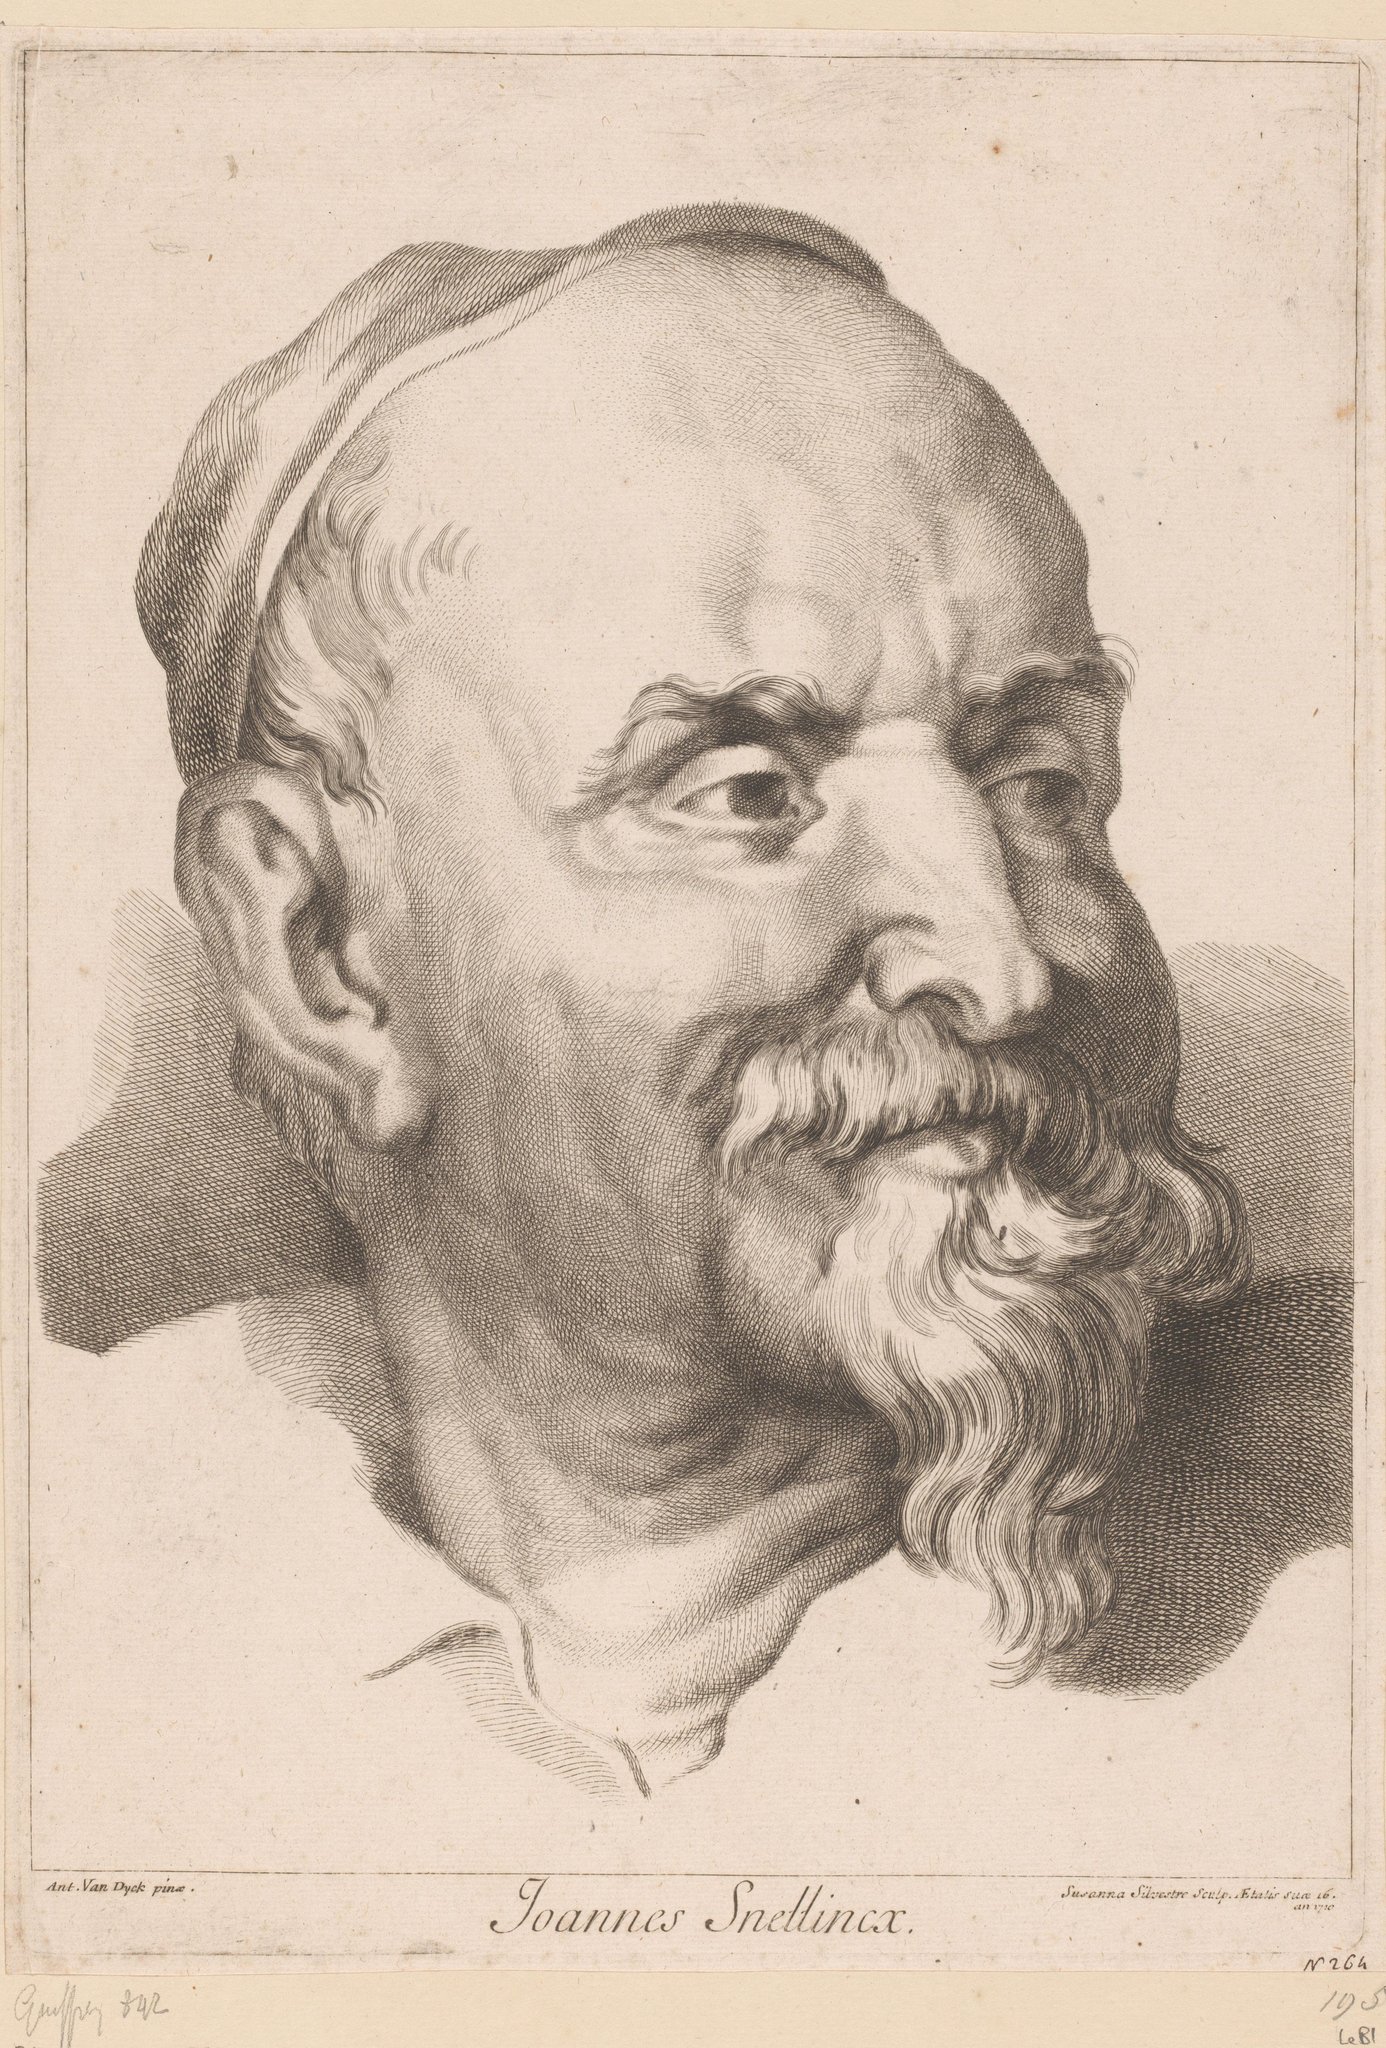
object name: print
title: Portret van Jan Snellinck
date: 1710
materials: paper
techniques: engraving, etching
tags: mechelen, antwerp, painter, draughtsman, jan snellinck (i), historical persons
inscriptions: collector's mark: Lugt 240